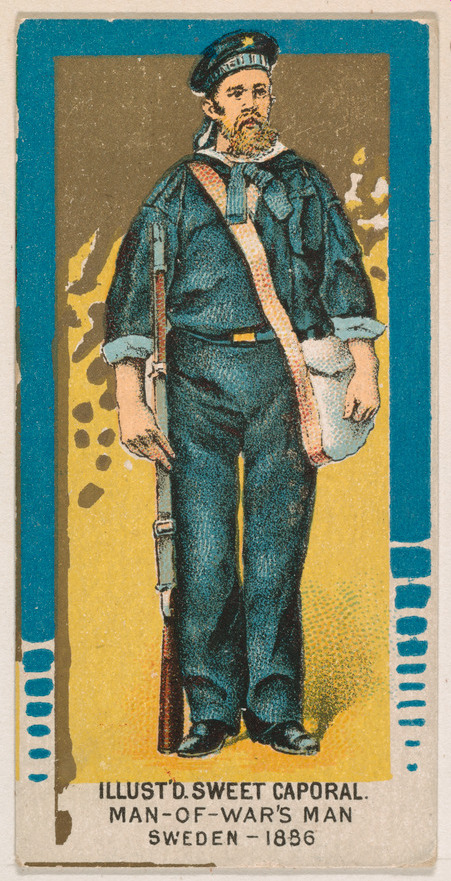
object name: print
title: Man-of-War's Man, Sweden, 1886, from the Military Series (N224) issued by Kinney Tobacco Company to promote Sweet Caporal Cigarettes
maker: kinney brothers tobacco company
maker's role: publisher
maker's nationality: american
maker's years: 1869-2011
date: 1888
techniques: color lithograph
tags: military,men